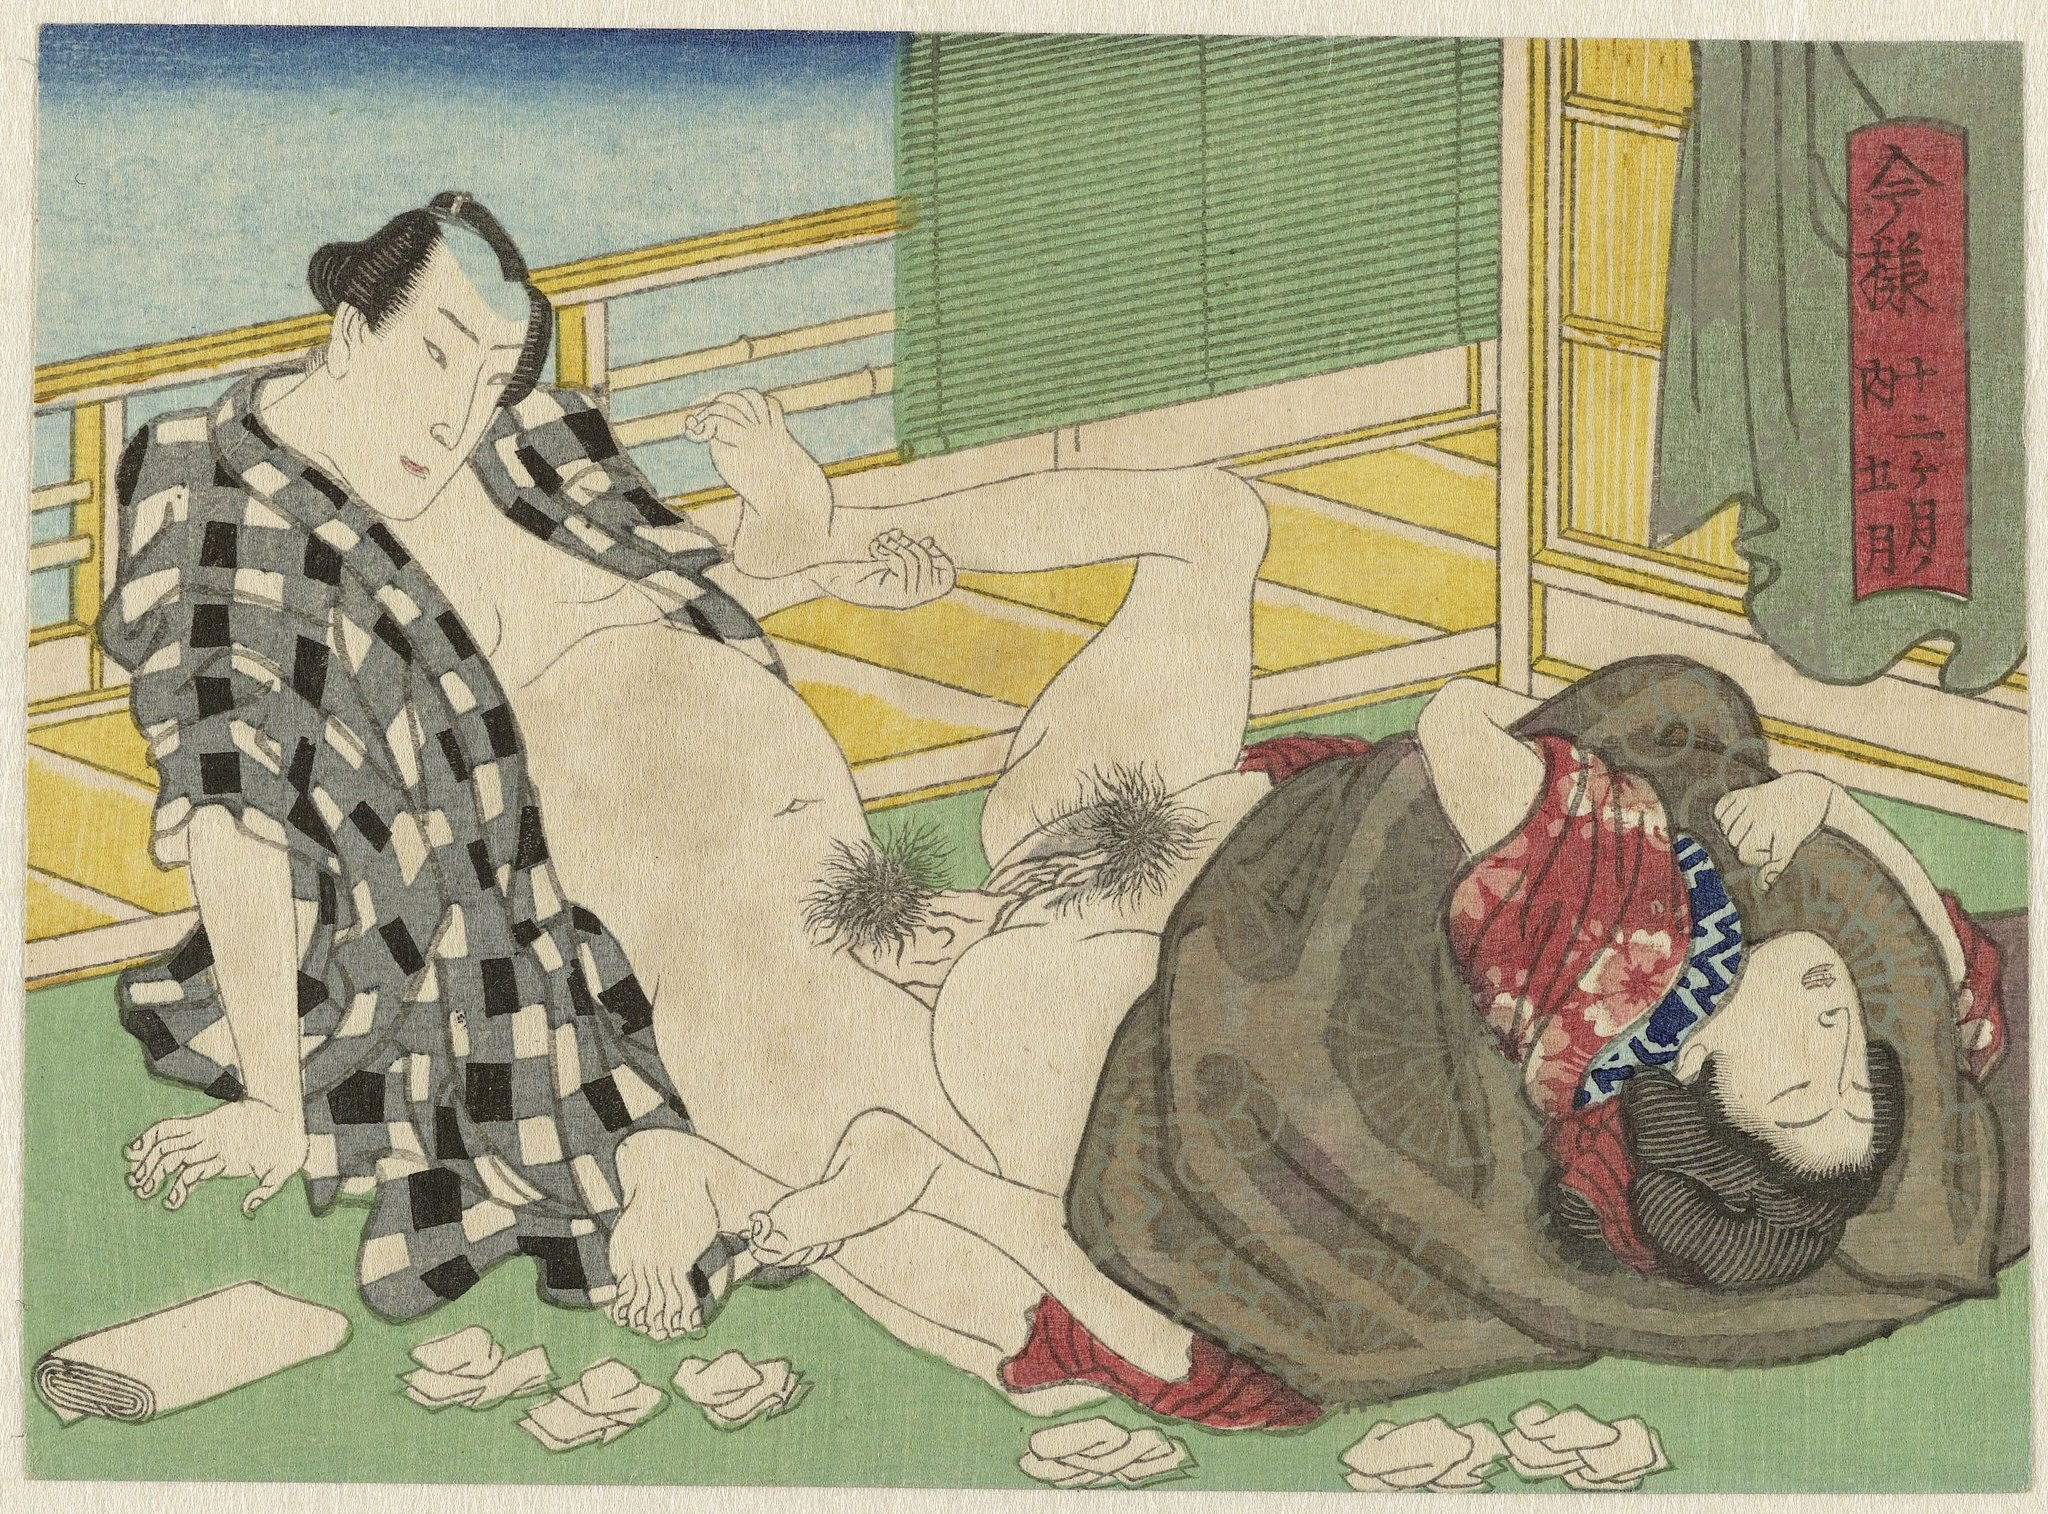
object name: shunga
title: Gogatsu, de vijfde maand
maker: Anonymous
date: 1835-1845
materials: paper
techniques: woodcut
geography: japan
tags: the twelve months of the year represented by concepts other than personifications, human activities, landscapes, or still lifes of flowers and/or fruits, coitus, cohabiting, sexual intercourse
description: De vrouw ligt achterover met omhoog gestoken benen. De man zit op zijn knieën en steunt een van haar benen. De deur naar de veranda staat open. De vele papiertjes - hanagami - die op de grond liggen, tonen aan dat de scène niet het begin is van de amoureuze activiteit.